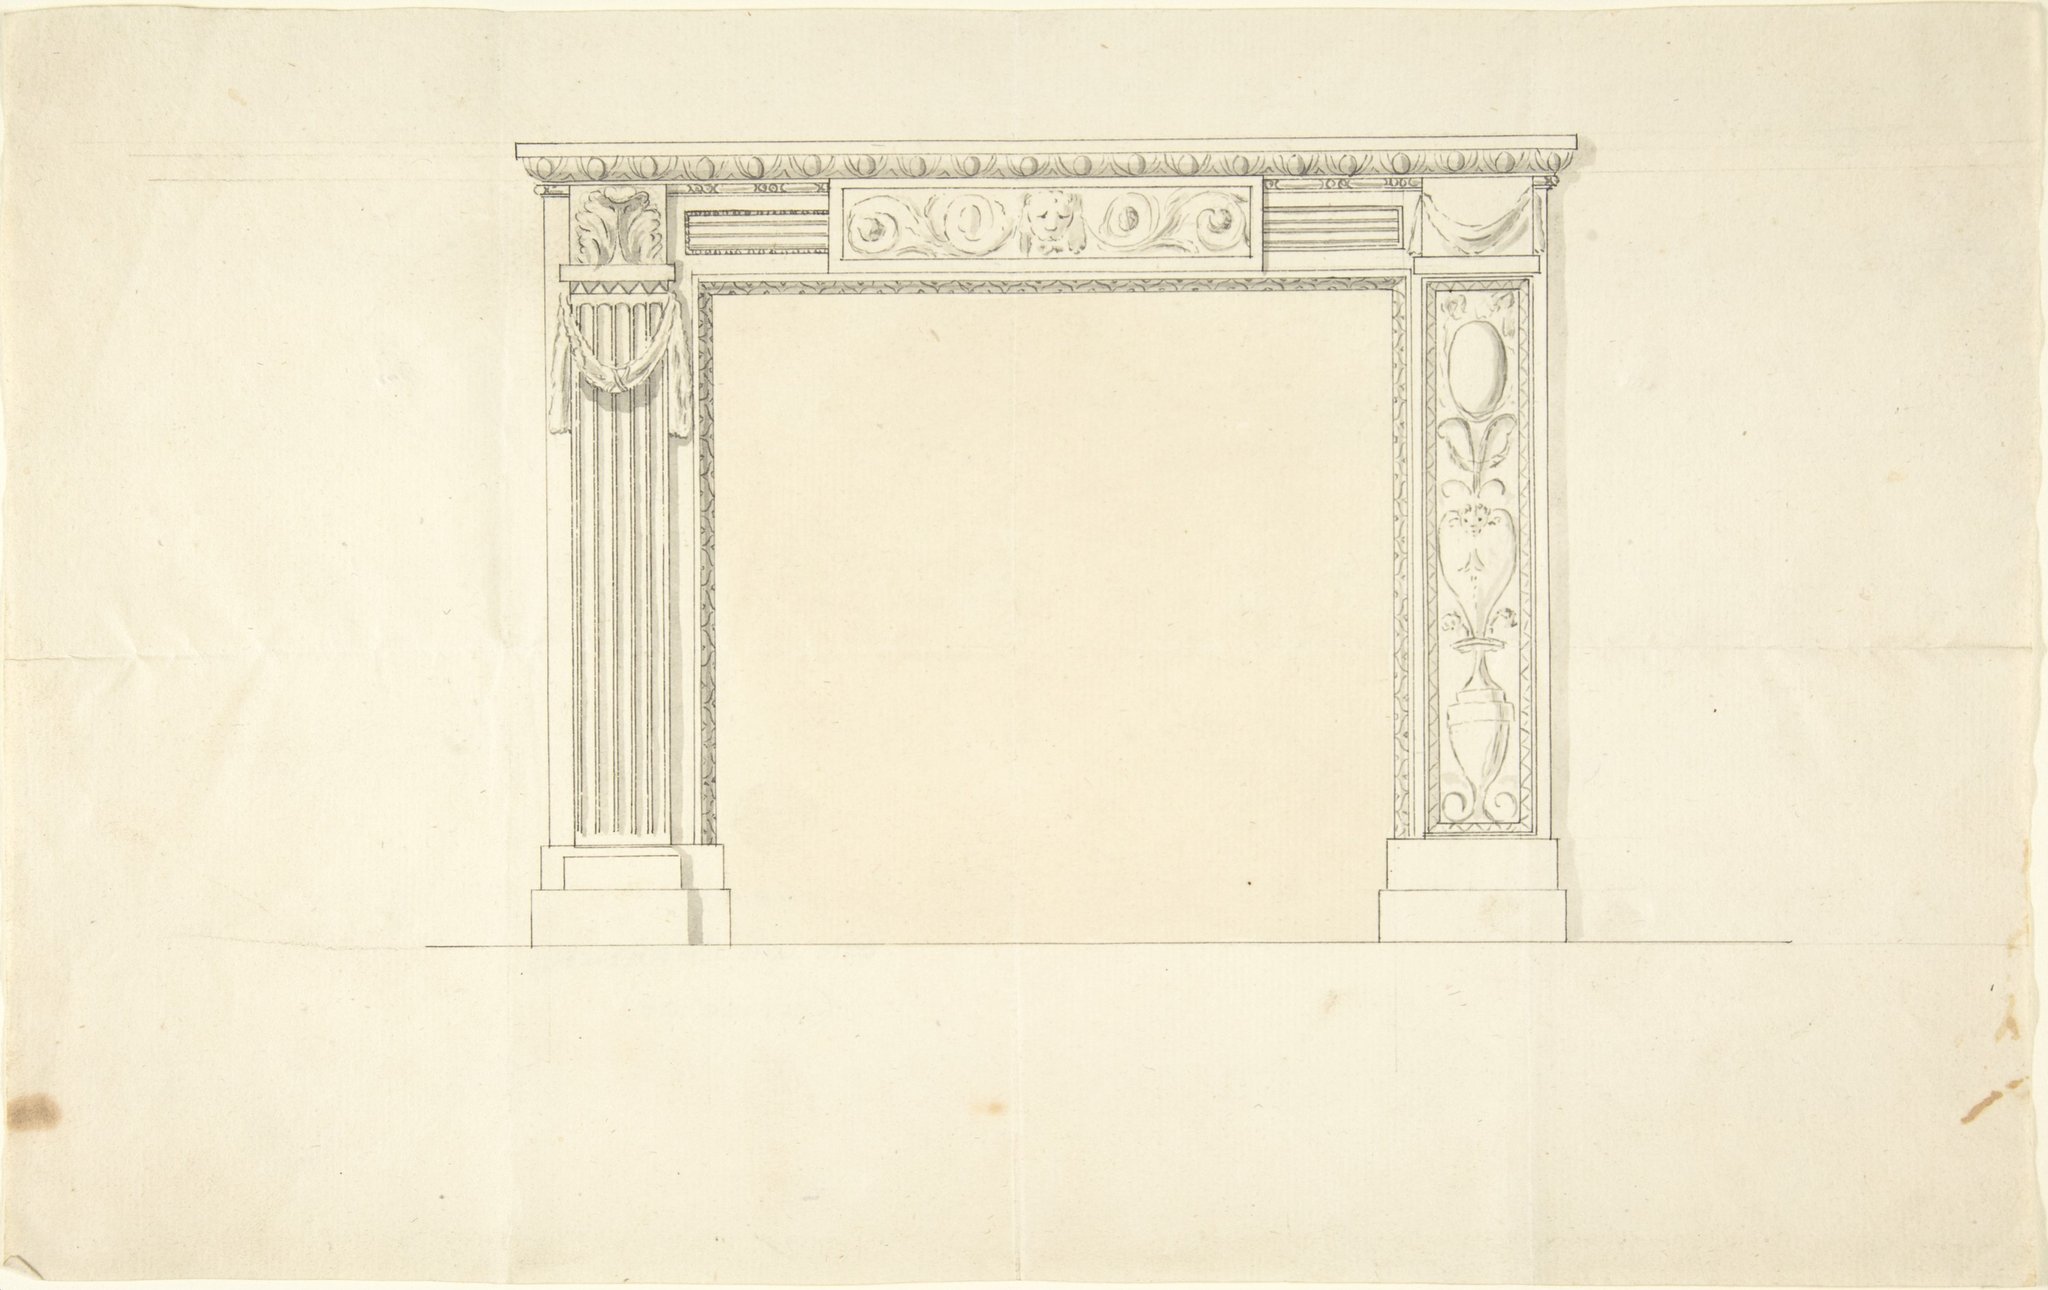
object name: drawing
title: Design for a Chimneypiece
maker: sir william chambers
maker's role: artist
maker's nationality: british, born sweden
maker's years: 1723-1796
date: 1740-1796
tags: fireplaces